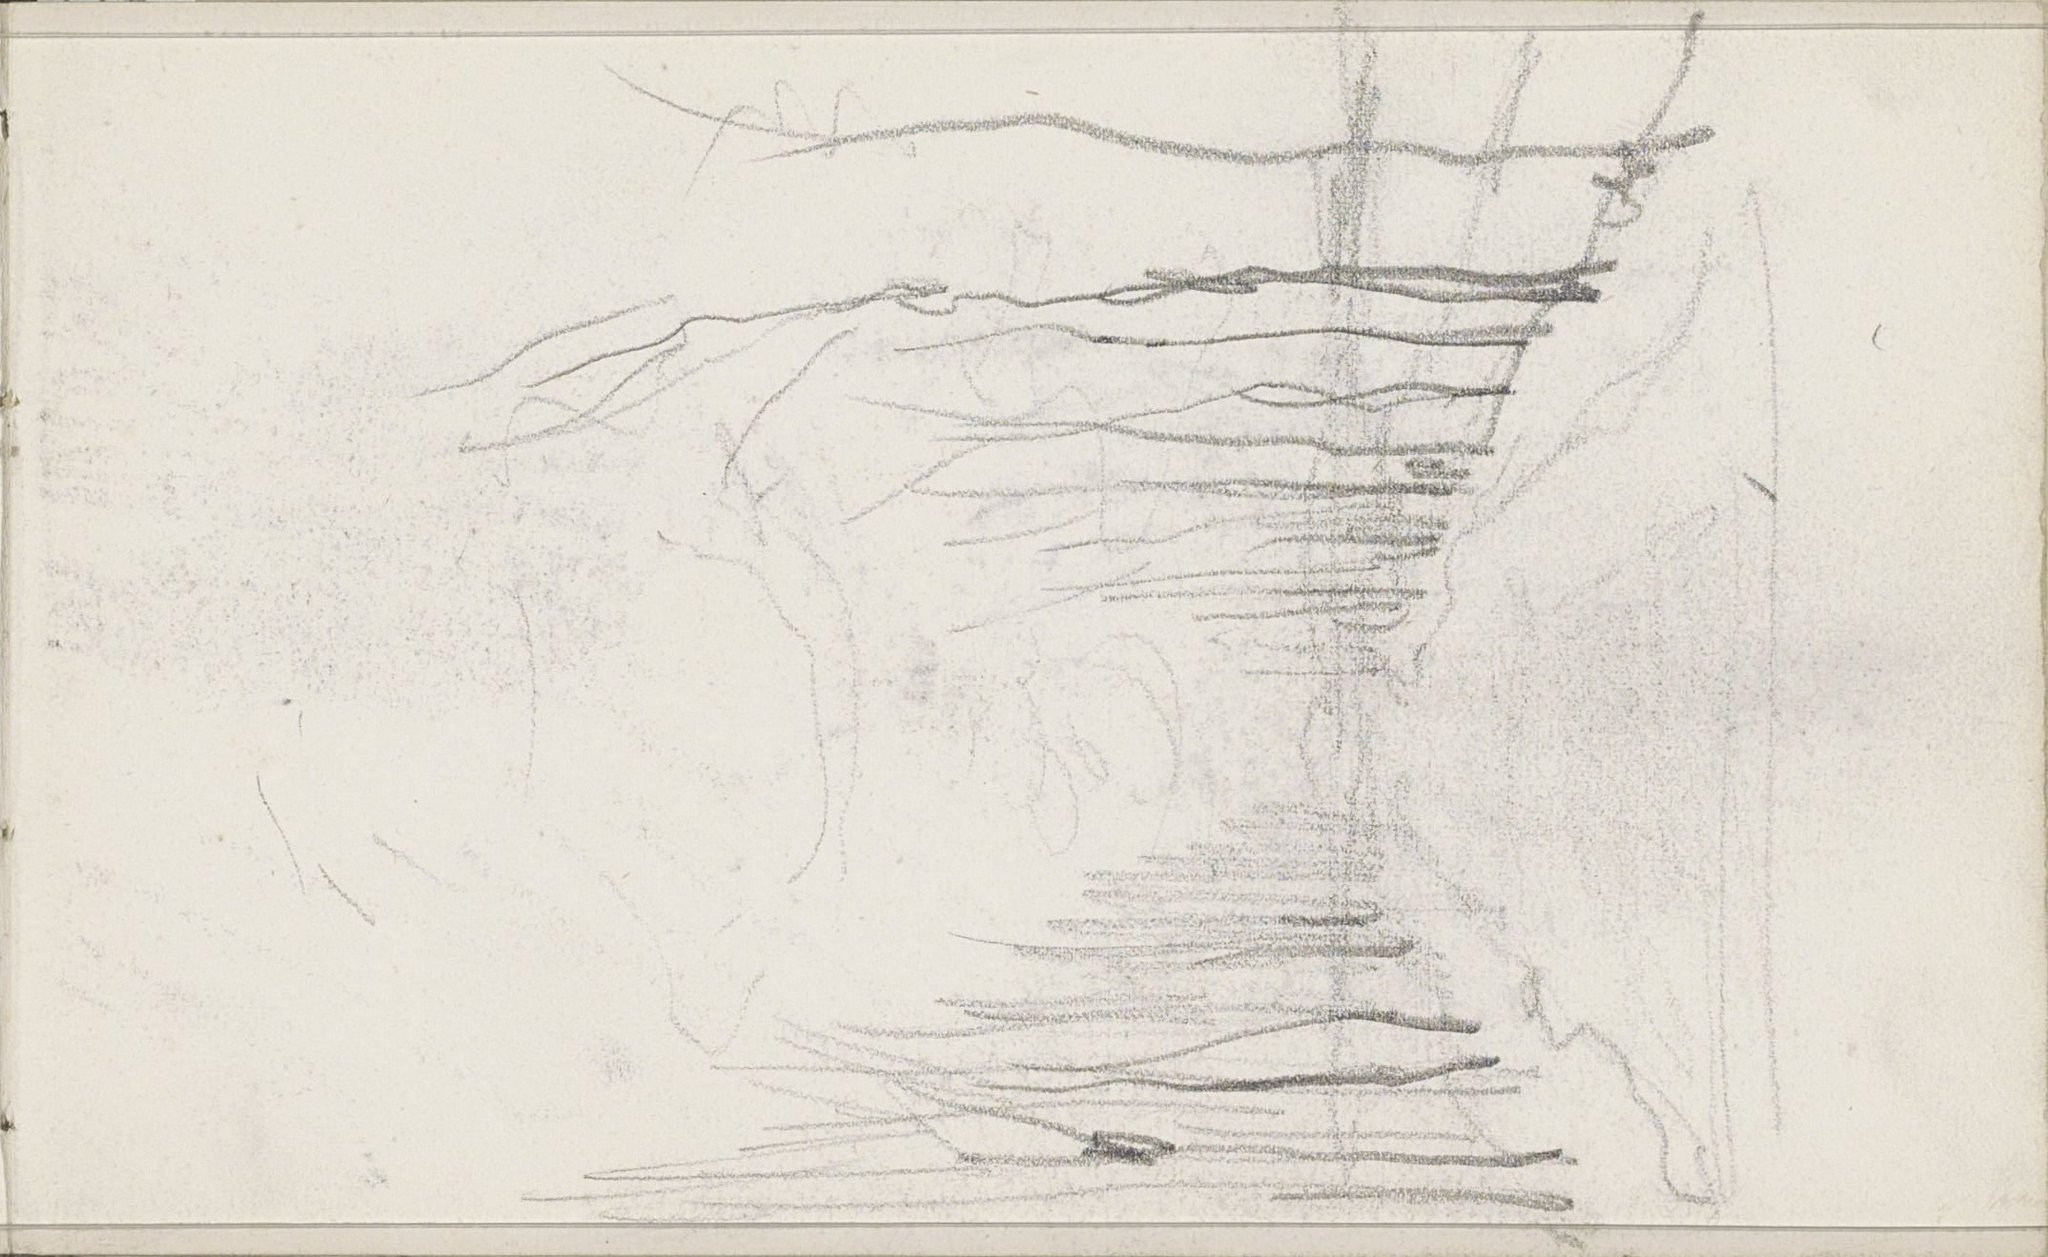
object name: sketchbook leaf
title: Bomen langs een landweg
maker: anton mauve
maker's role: draughtsman, painter, print maker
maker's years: 1838-1888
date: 1848-1888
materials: paper, pencil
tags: road, path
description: Blad 3 recto uit een schetsboek met 43 bladen.